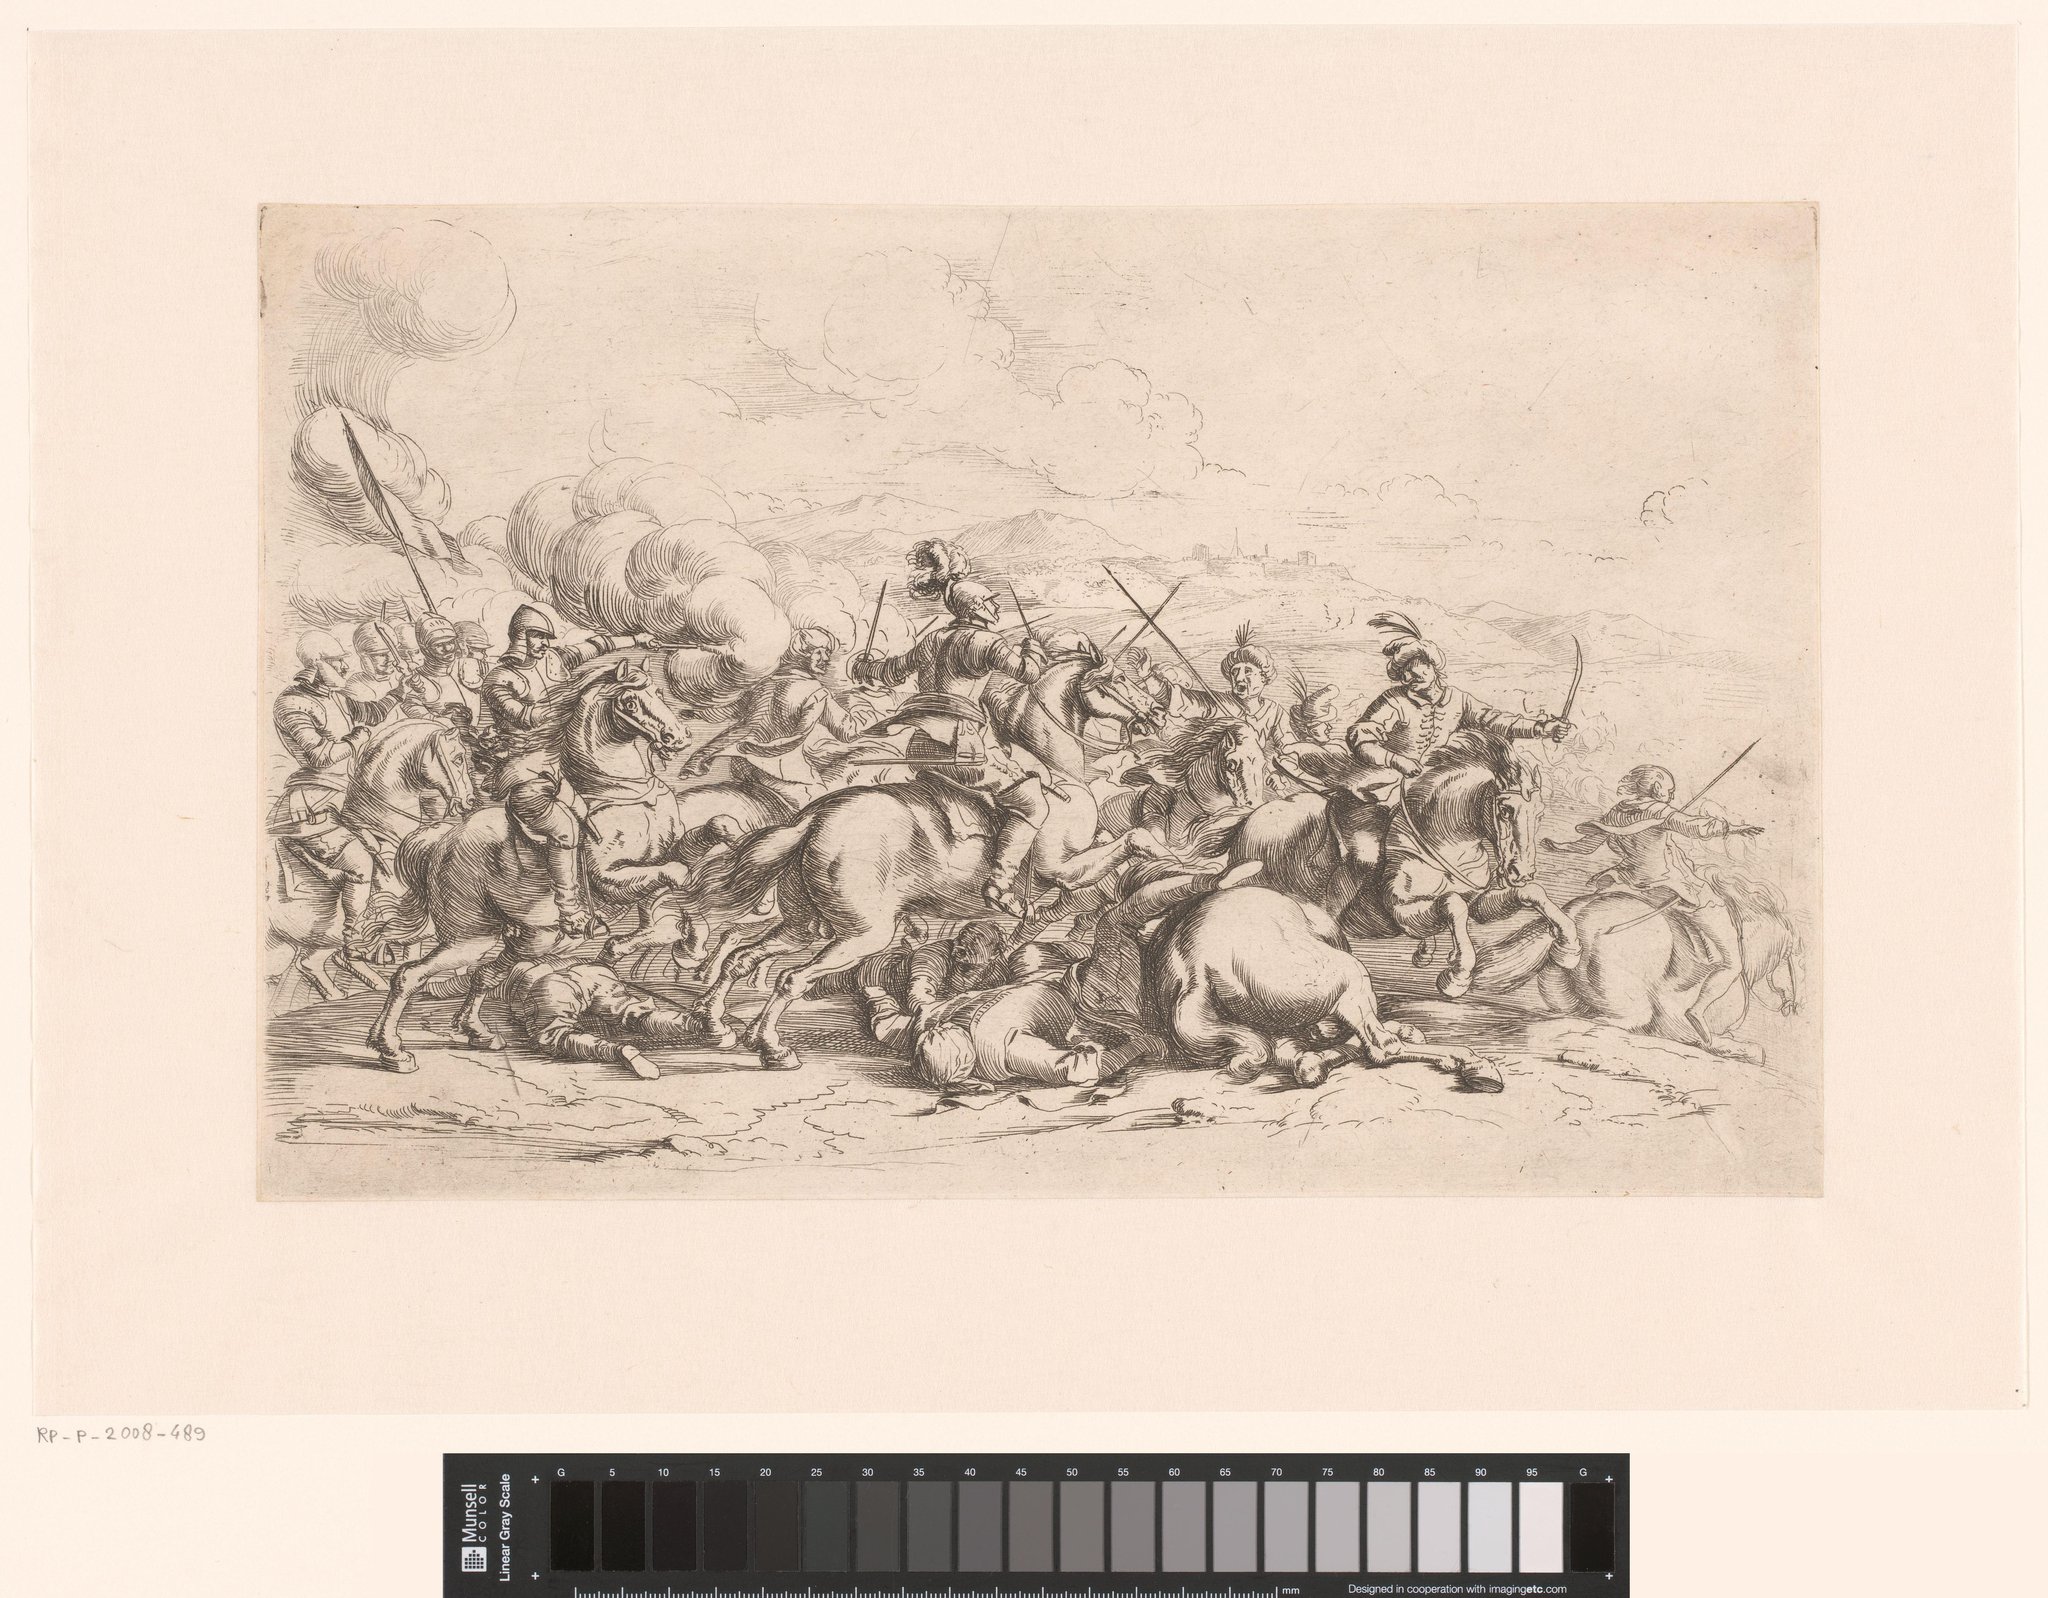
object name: print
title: Ruitergevecht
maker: jacques courtois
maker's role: painter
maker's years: 1621-1676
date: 1631-1676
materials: paper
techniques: etching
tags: battle, attack ~ siege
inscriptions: collector's mark: Lugt 2760, collector's mark: Lugt 2228